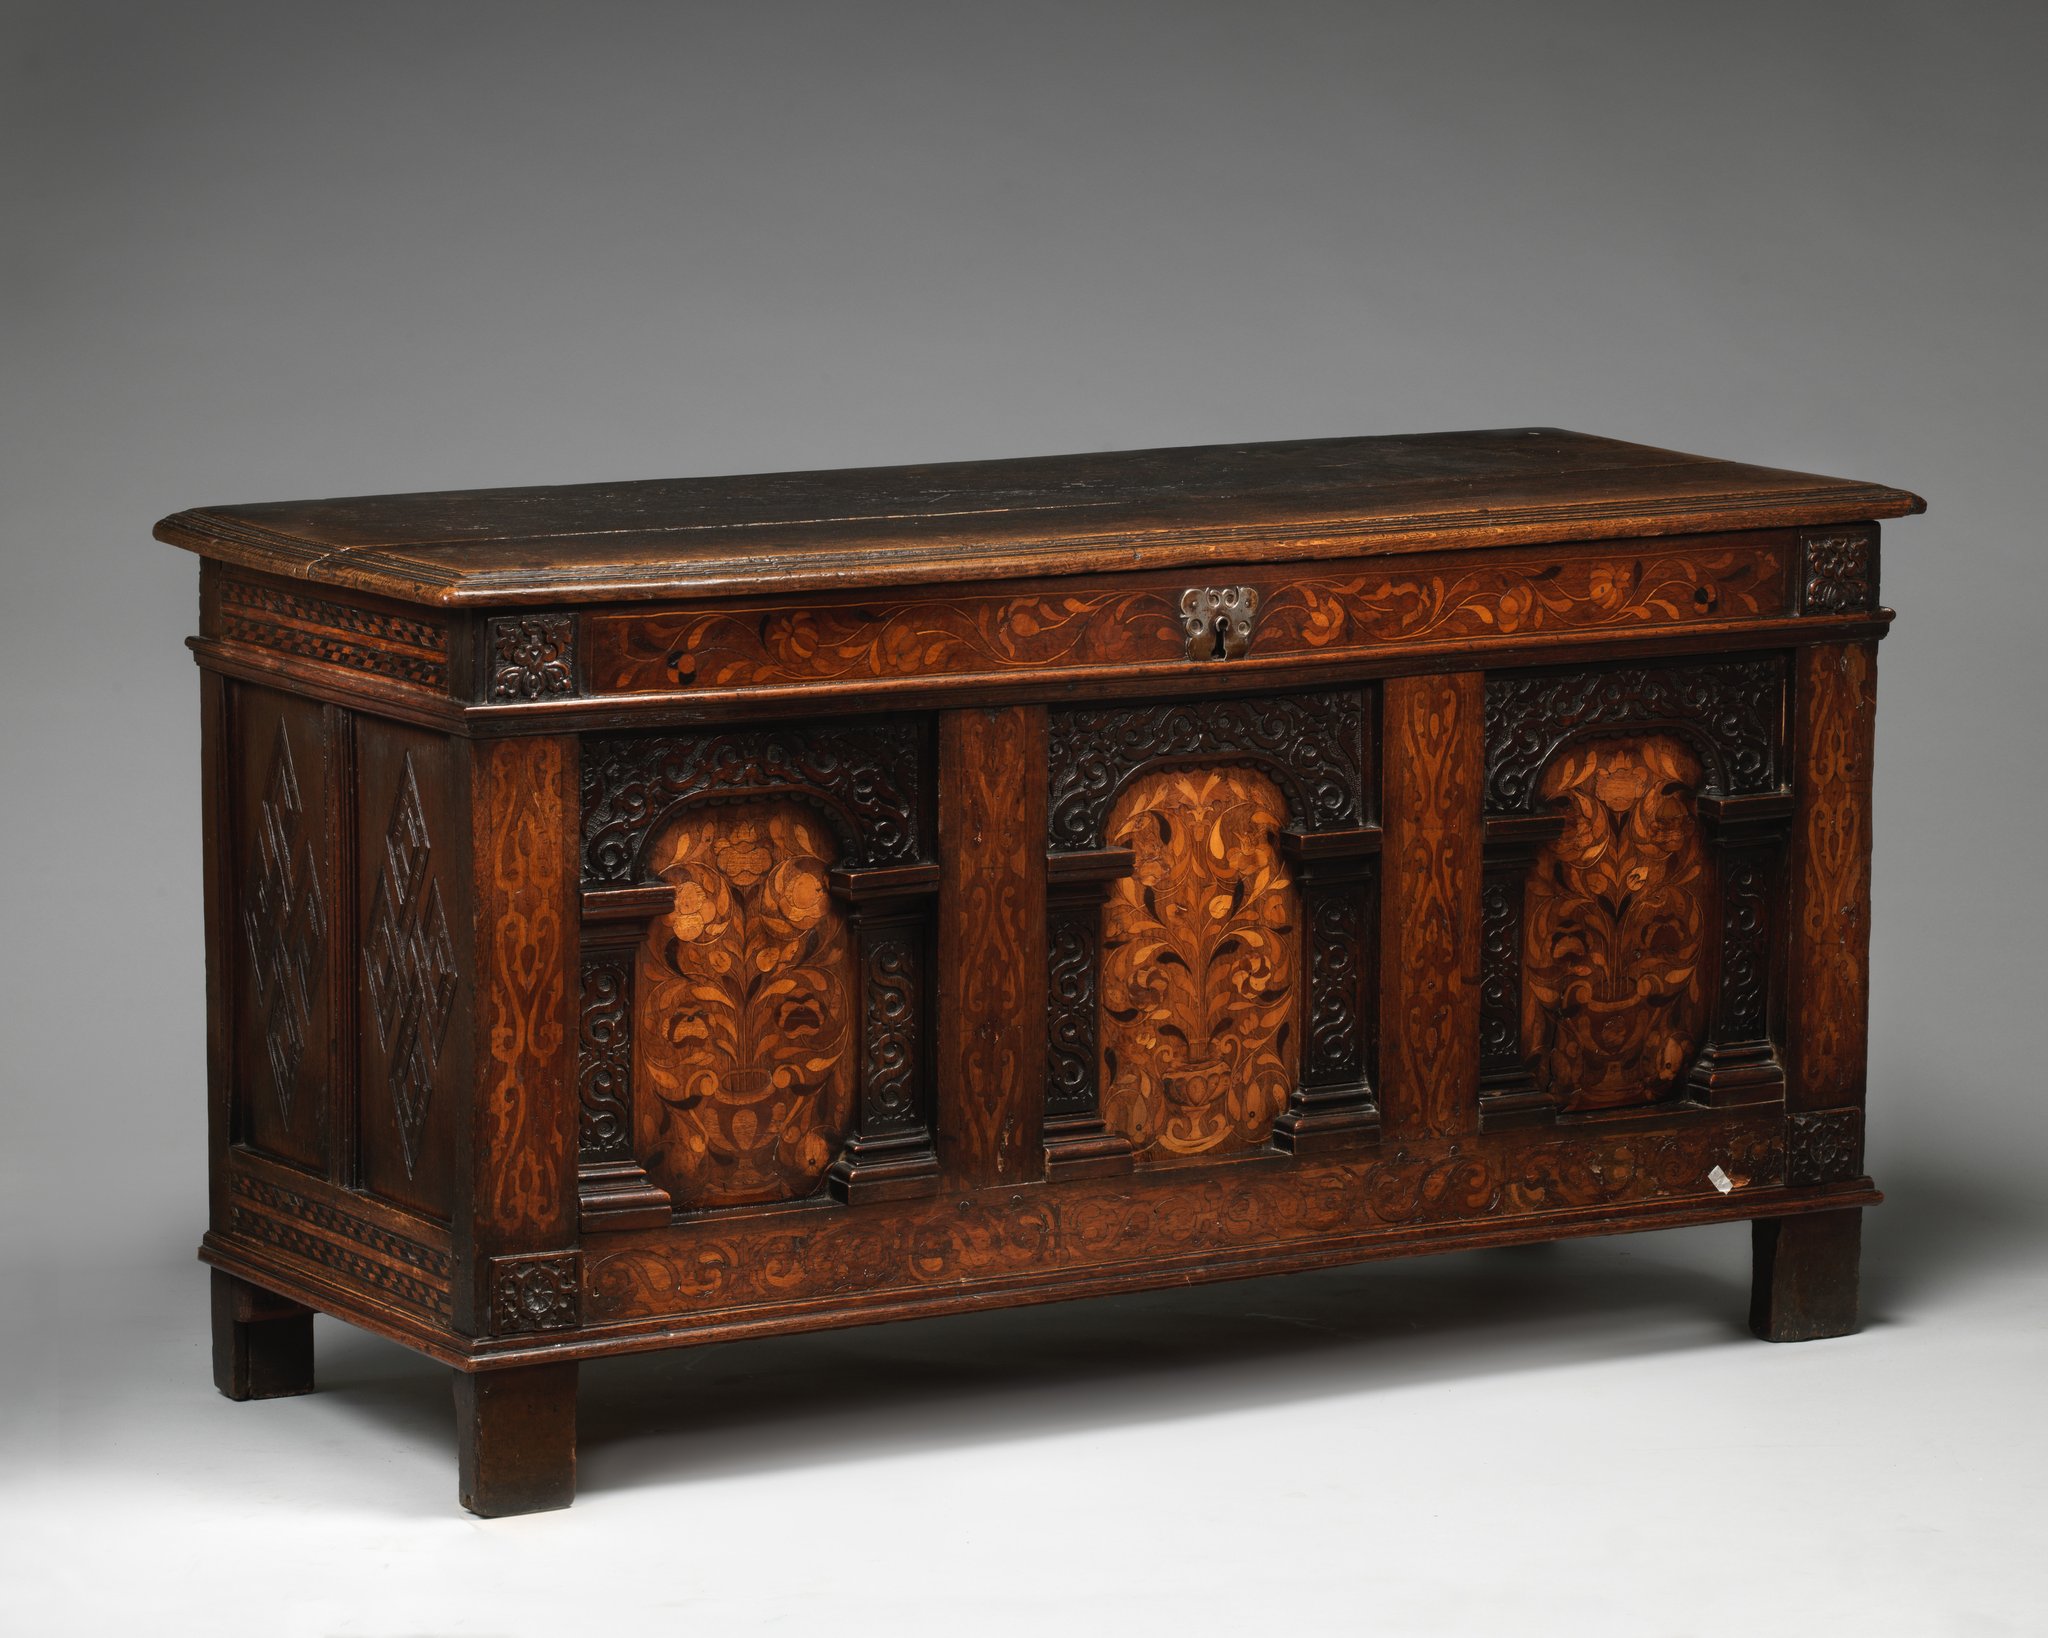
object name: chest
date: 1600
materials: wood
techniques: inlay